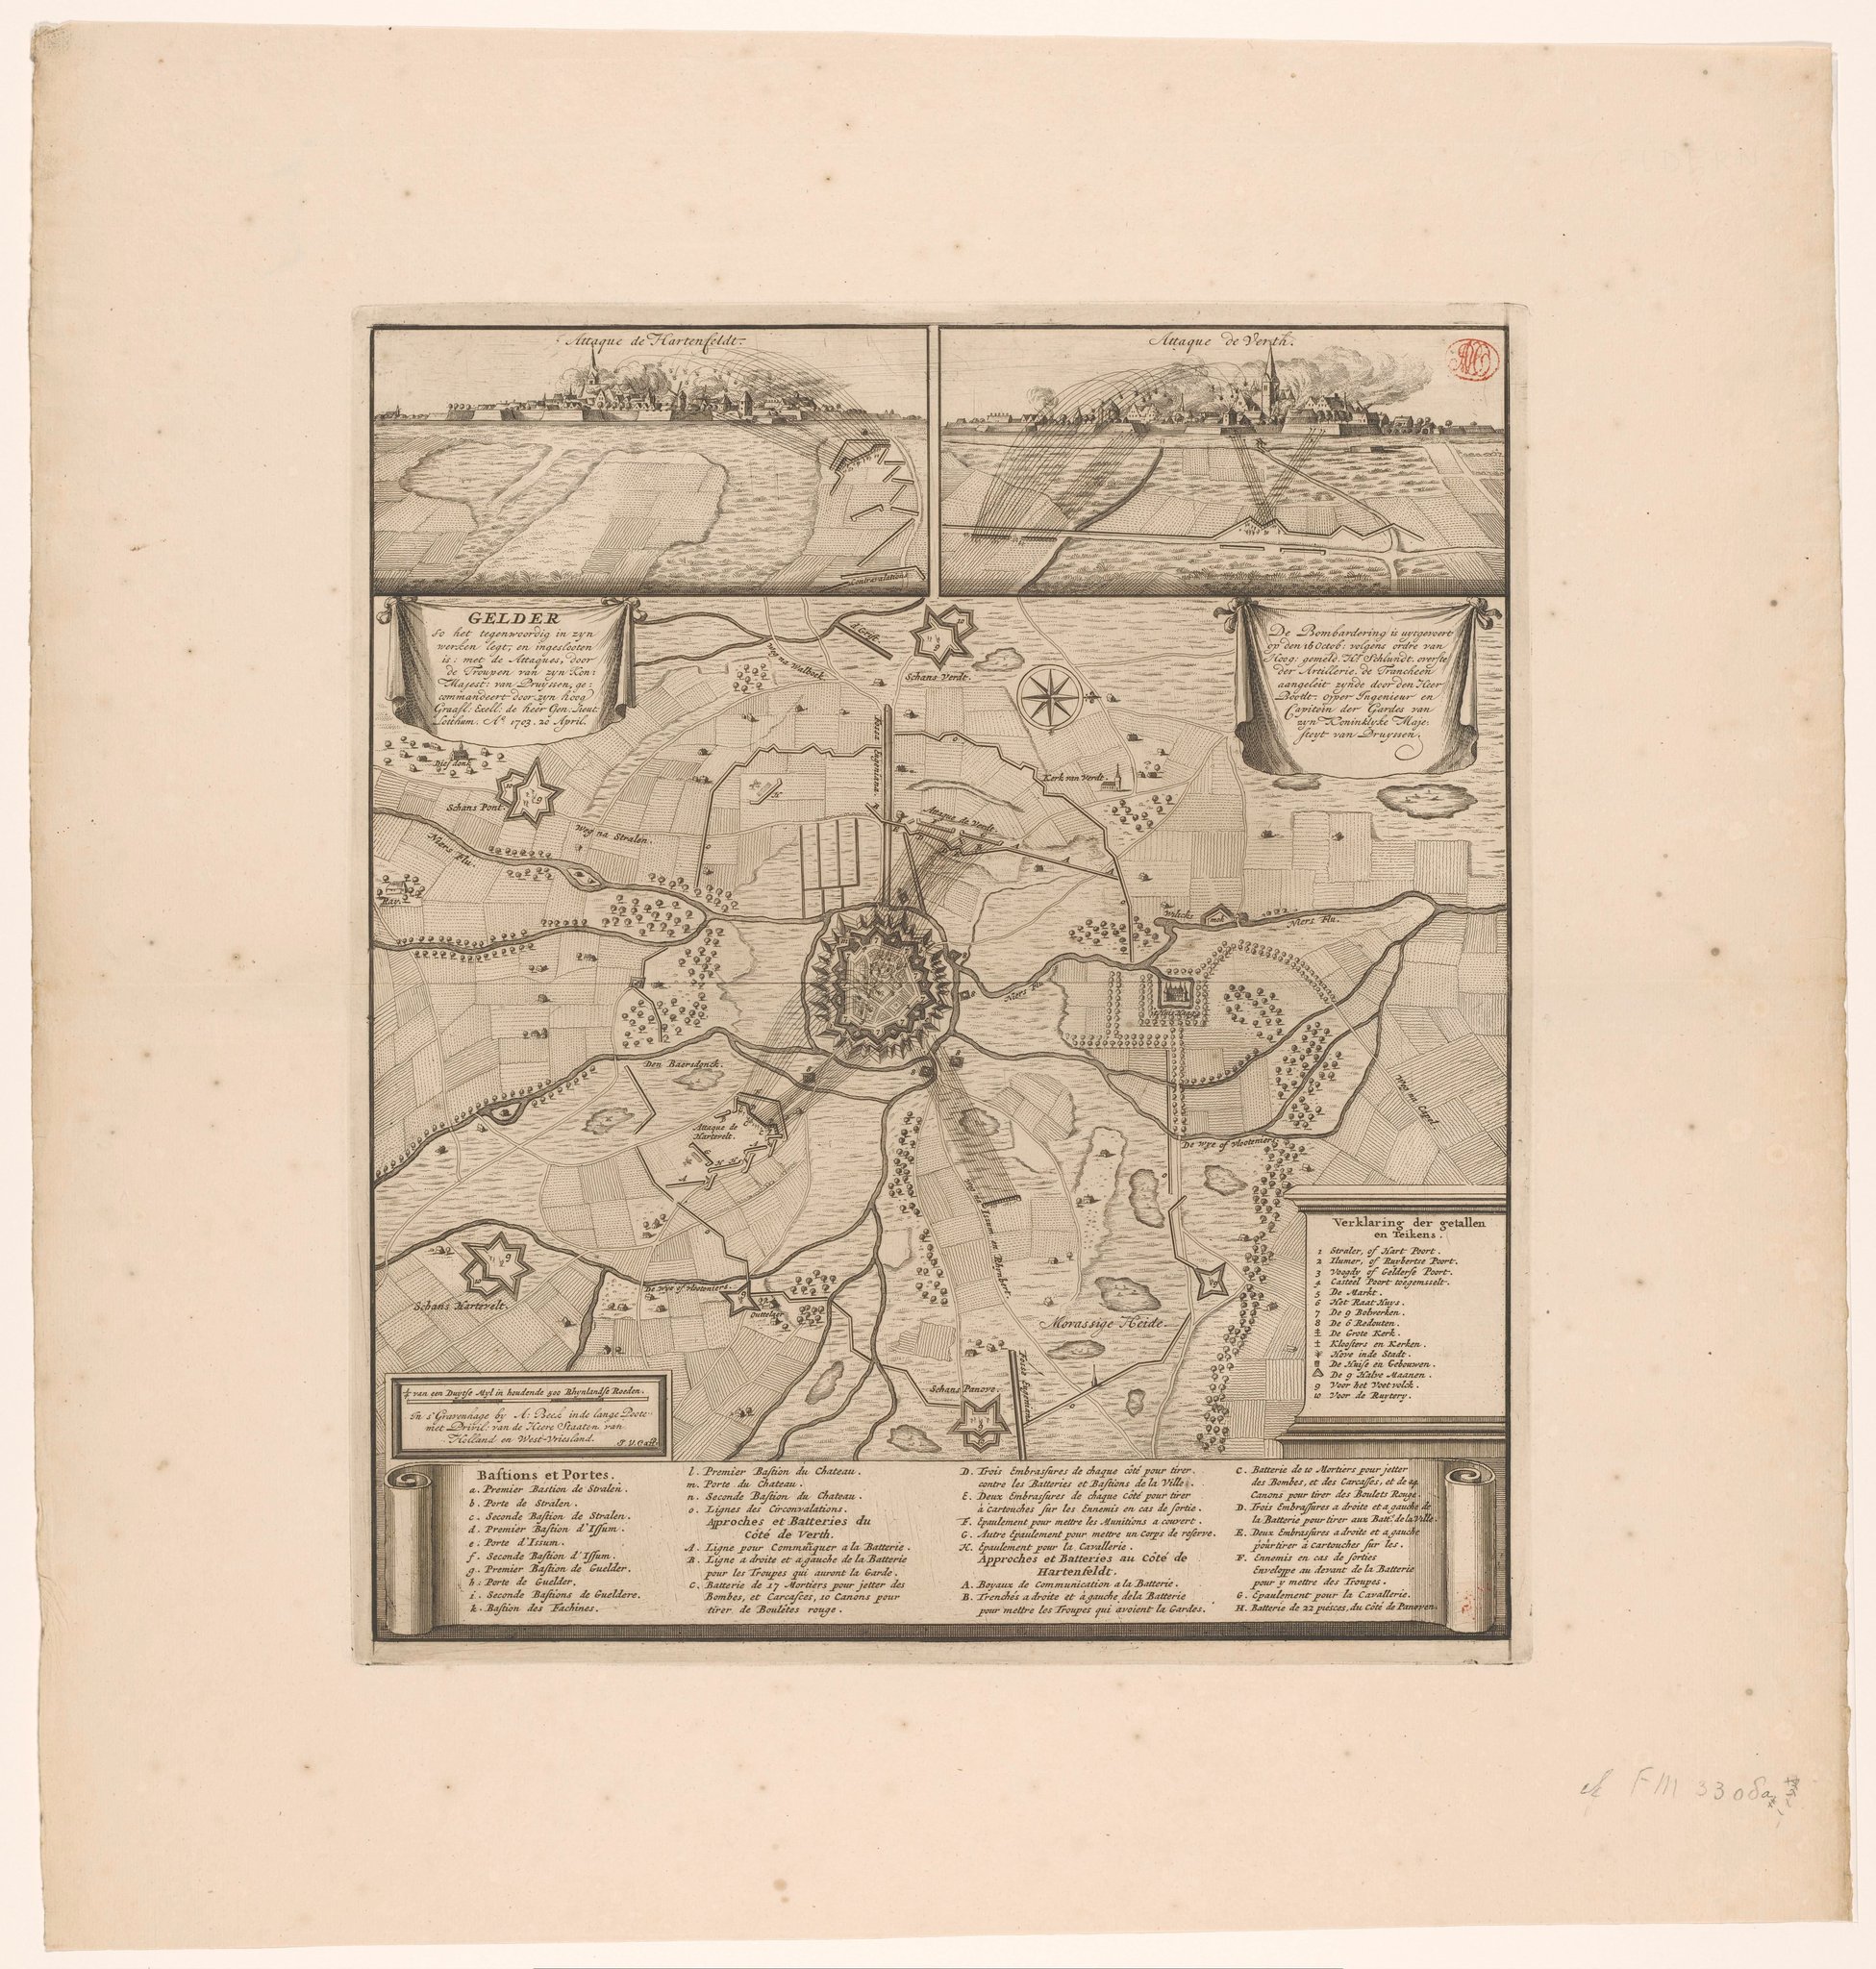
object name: map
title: Beleg van Geldern, 1703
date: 1703-1717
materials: paper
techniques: engraving, etching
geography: the hague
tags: siege, position war, maps of cities, bombardment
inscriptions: collector's mark: Lugt 195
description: Kaart van Geldern en omgeving, tijdens het beleg door de Pruisische troepen onder generaal Lotthum op 20 april. Bovenaan het bombardement van de stad op 7 oktober 1703 gezien vanuit Hartenfeldt en Verth. Onderaan de verklaringen in het Frans.